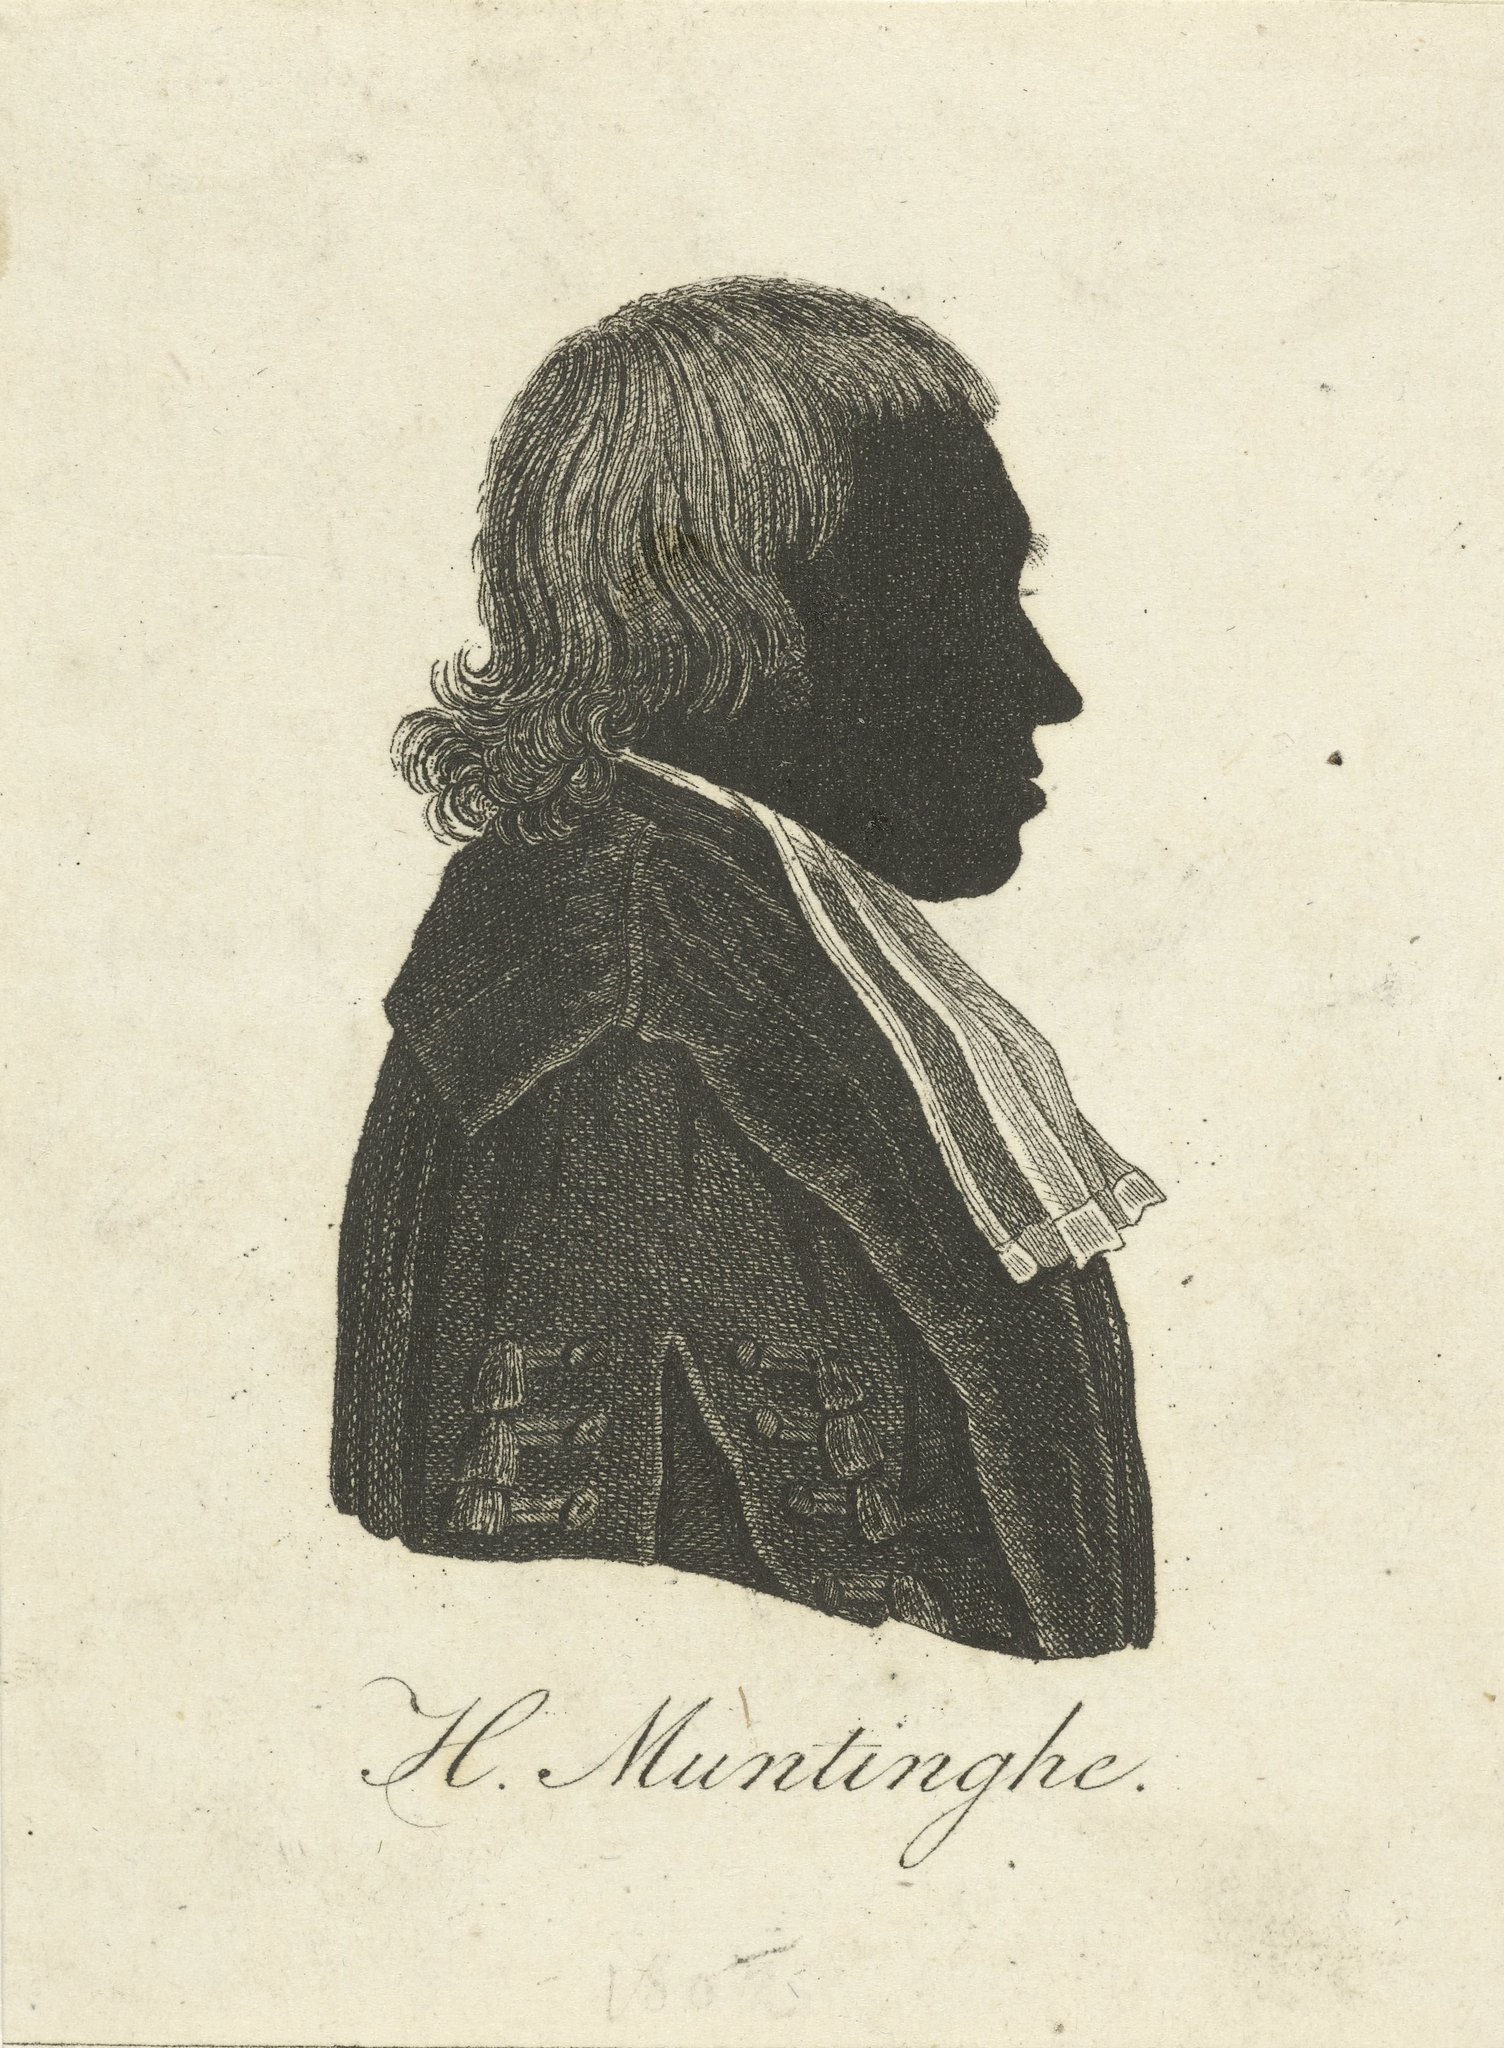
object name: print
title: Silhouetportret van Herman Muntinghe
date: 1802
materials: paper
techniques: etching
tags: termunten, leeuwarden, professor in de theologie, herman muntinghe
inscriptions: collector's mark: Lugt 2228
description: Silhouetportret van Herman Muntinghe, buste naar rechts.